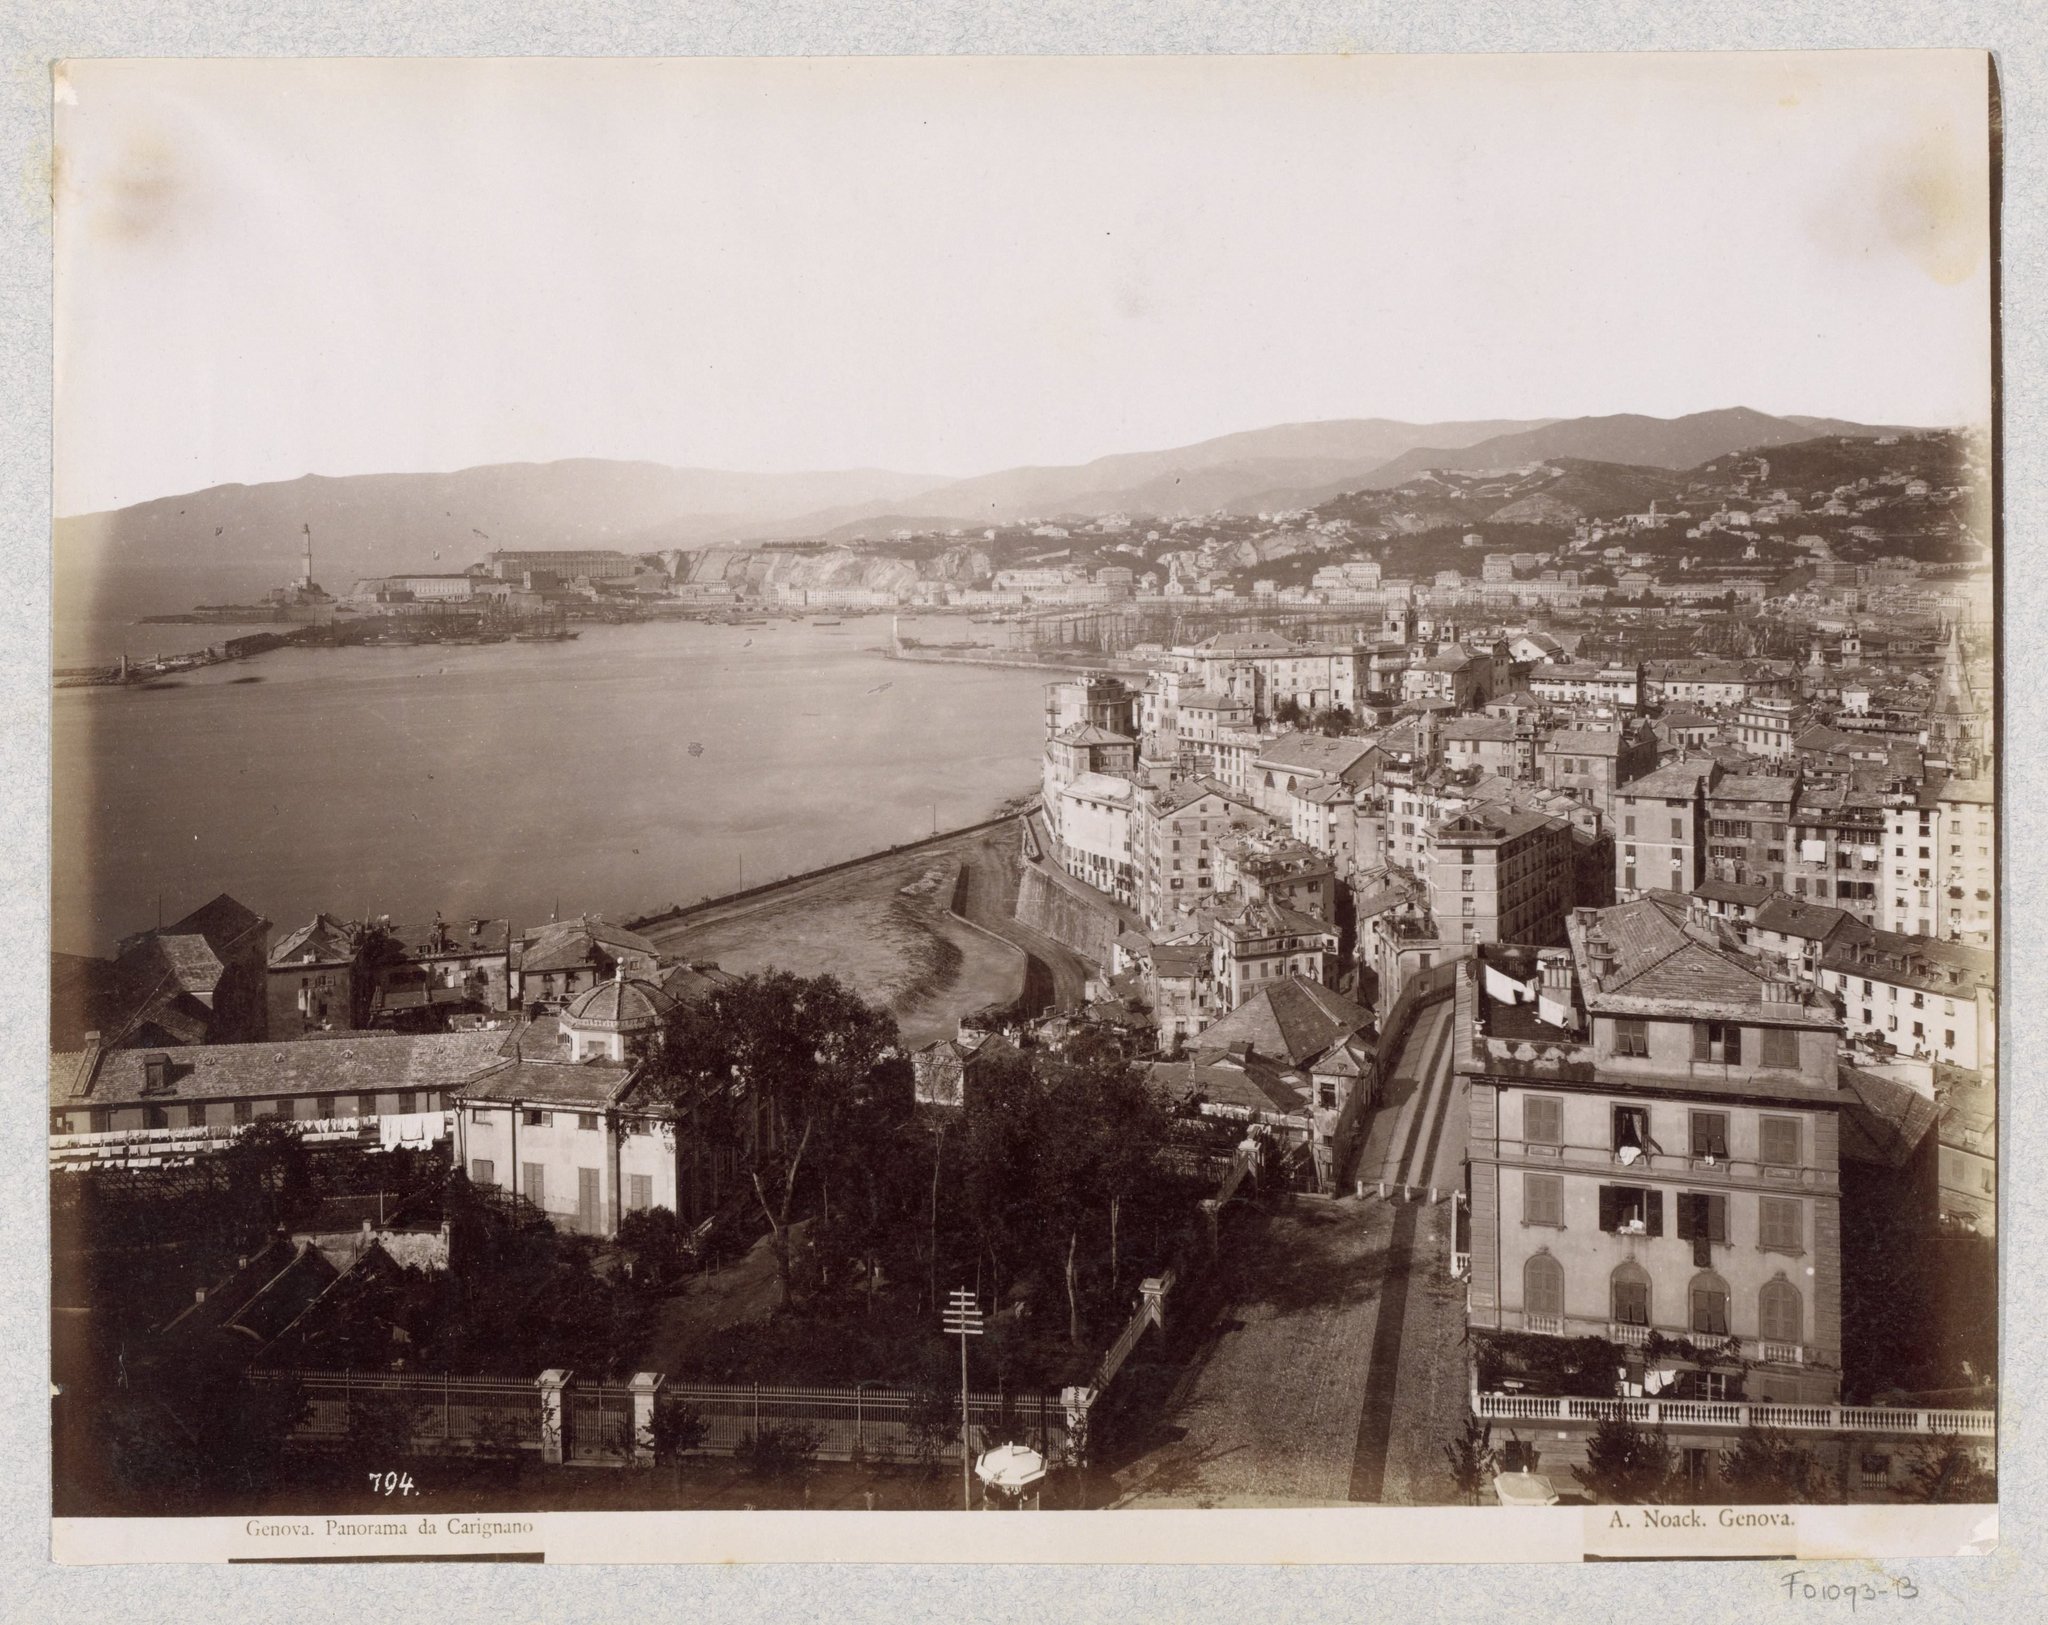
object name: photograph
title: Gezicht op de wijk Carignano in Genua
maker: alfredo noack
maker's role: fotograaf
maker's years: 1833-1895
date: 1870-1890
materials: paper, photographic support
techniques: albumen print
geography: genoa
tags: harbour (+ view ~ vehicle, ship, etc.), prospect of city, town panorama, silhouette of city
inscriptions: negative number: ‘794’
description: Onderdeel van Reisalbum met foto's van bezienswaardigheden in Genua, Florence en Venetië.